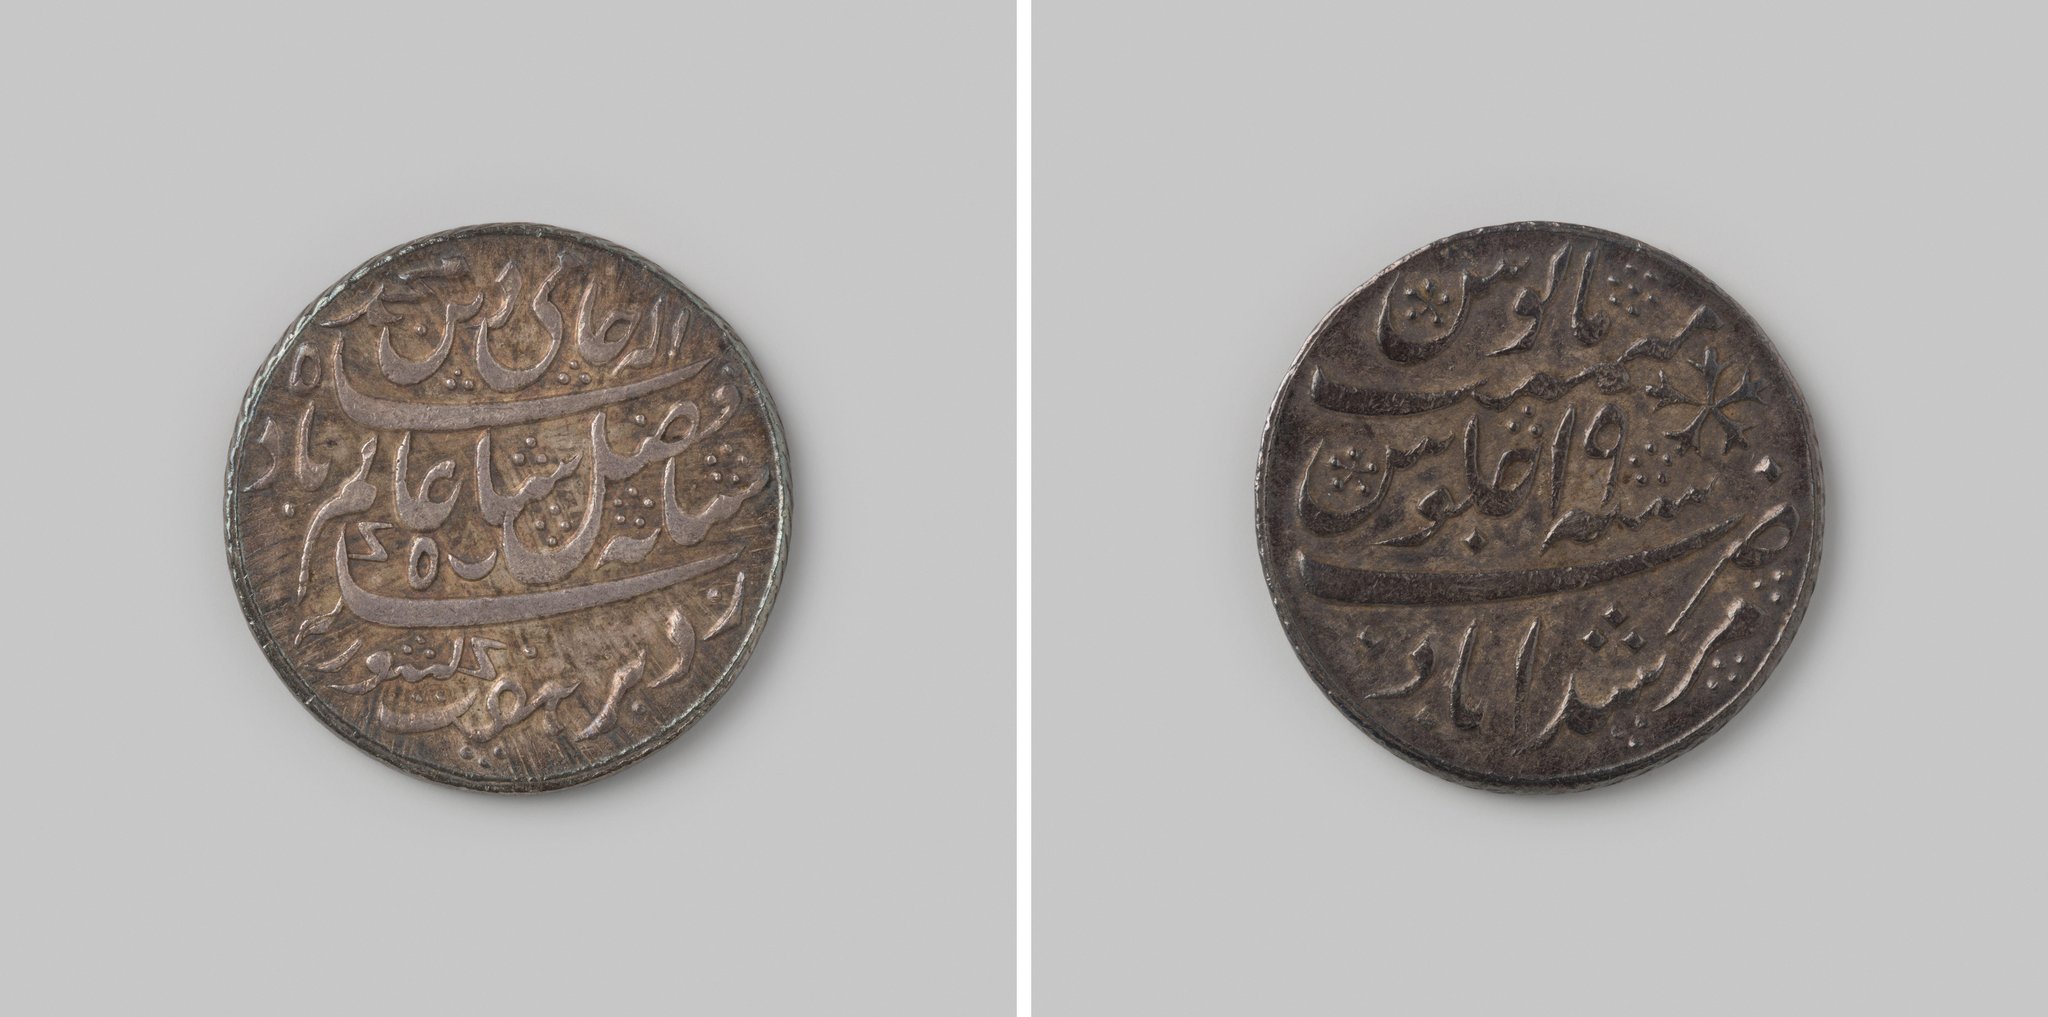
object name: coin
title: ½ roepie uit Bengalen in India van de Engelse Oostindische Compagnie (EIC) op naam van Sjah Alam I, regeringsjaar 19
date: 1793-1818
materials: silver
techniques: striking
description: Zilveren munt. Voorzijde: in Arabische lettertekens in drie regels opschrift. Keerzijde: in Arabische lettertekens in drie regels opschrift. Boven tweede regel aanduiding van het "eeuwige" regeringsjaar: 19. Kabelrand.